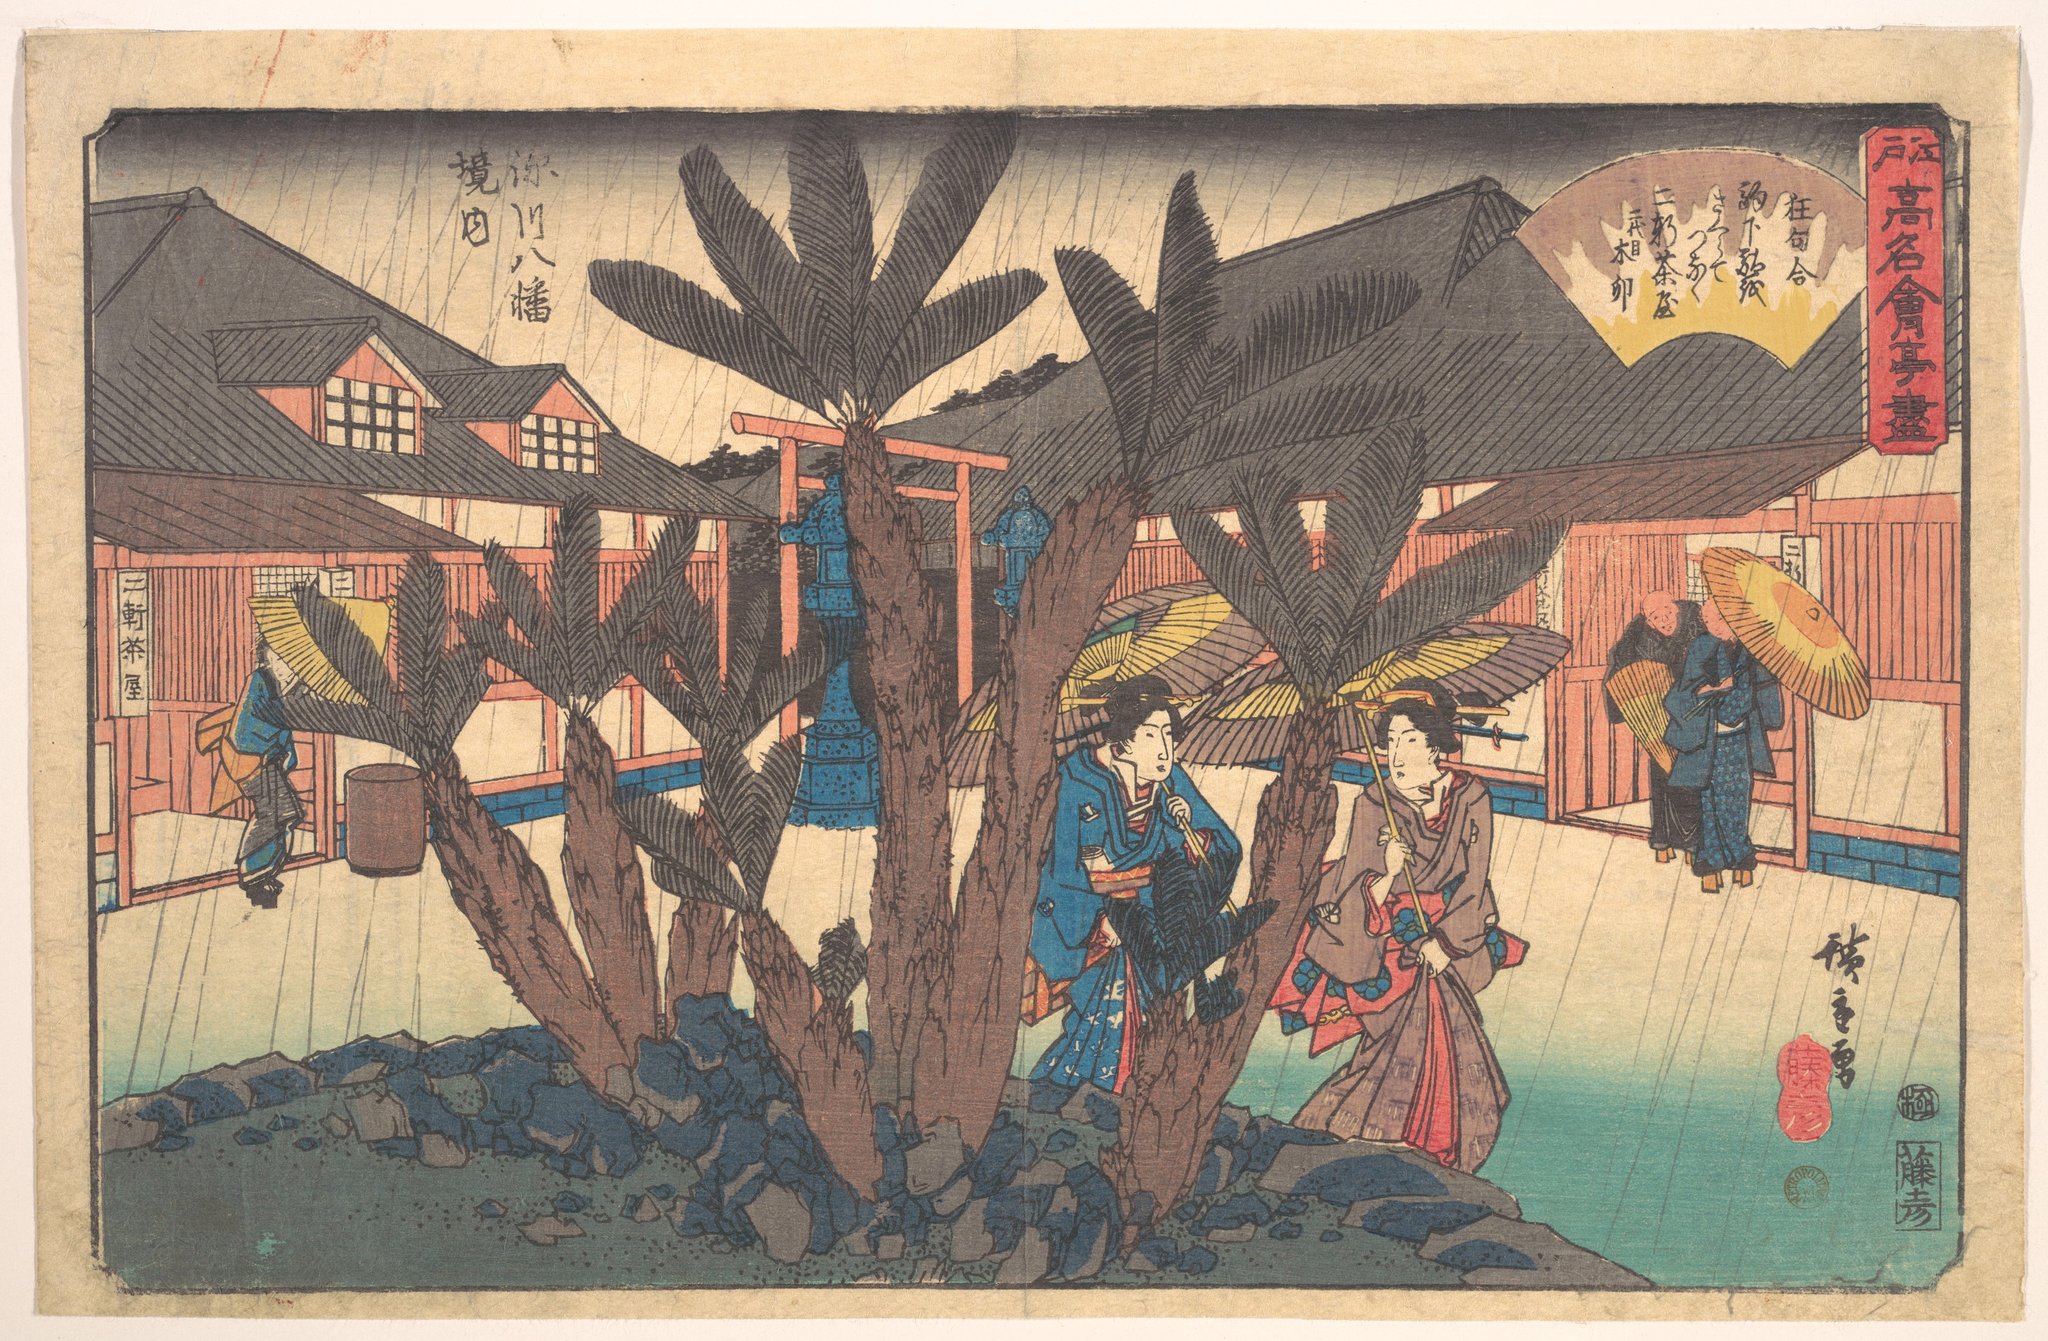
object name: print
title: Fukagawa Hachiman Keidai (Niken Jya-ya)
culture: japanese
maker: utagawa hiroshige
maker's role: artist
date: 1840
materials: ink, paper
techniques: woodblock print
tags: men,women,trees,umbrellas,tea houses